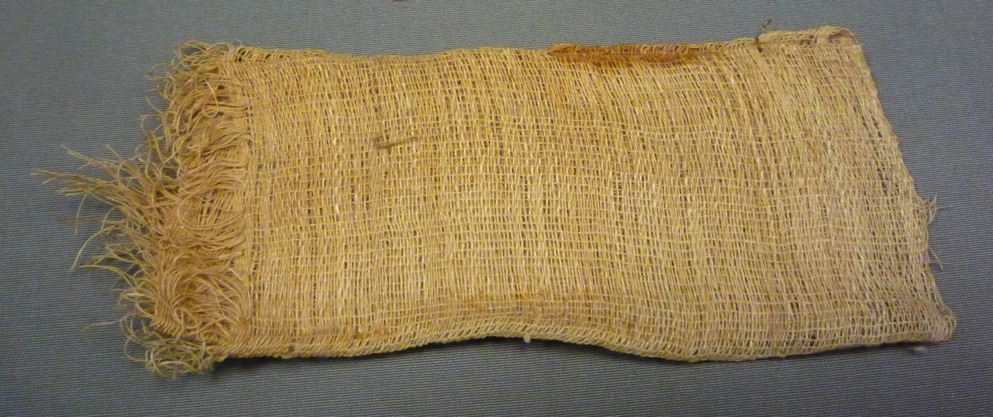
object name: model sheet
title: Model Sheet from the Foundation Deposit for Hatshepsut's Tomb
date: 1479-1458 BCE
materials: linen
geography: egypt